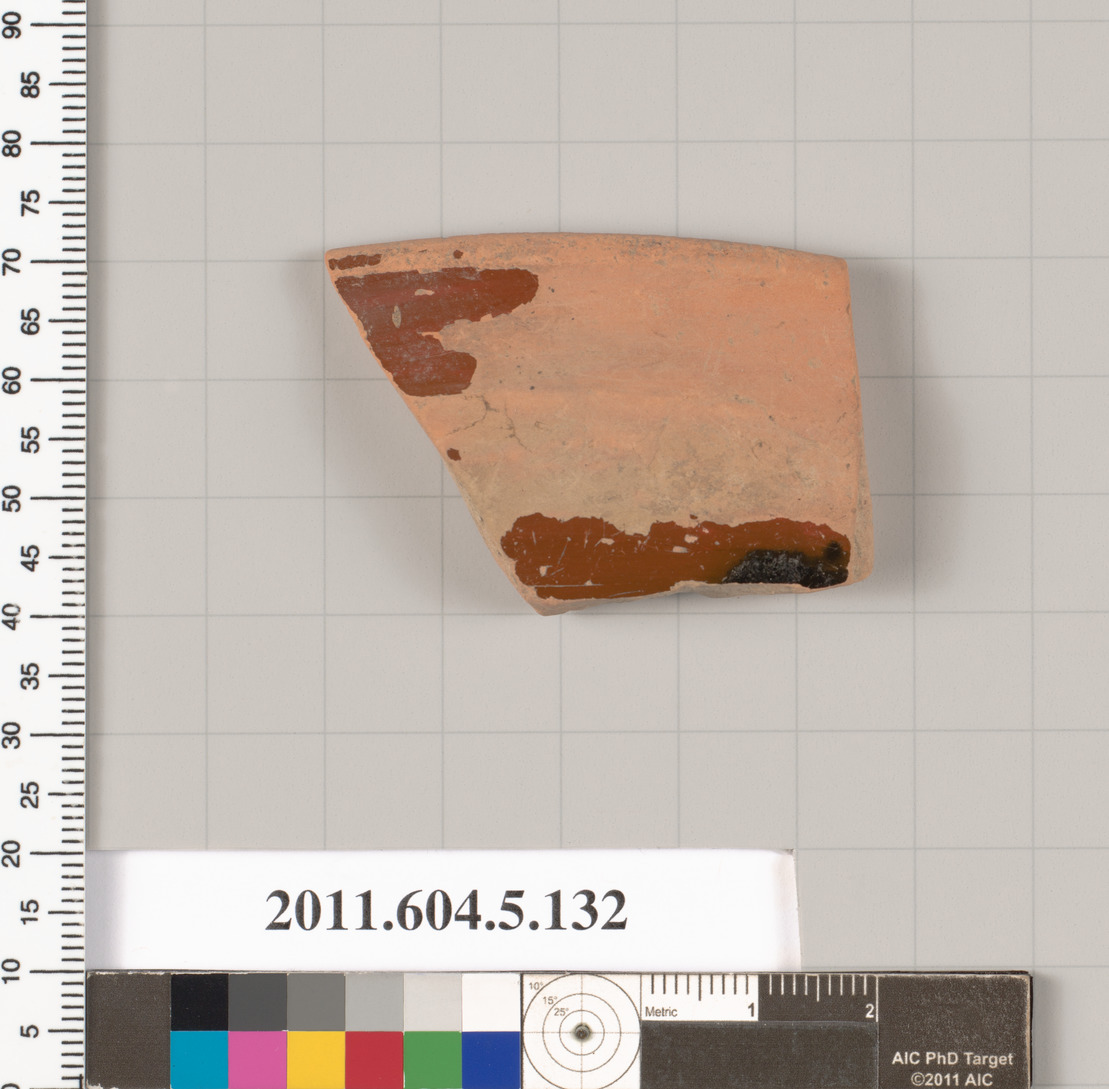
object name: kylix fragment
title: Terracotta rim fragment of a stemless kylix (drinking cup)?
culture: greek, attic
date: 470-450 BCE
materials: terracotta